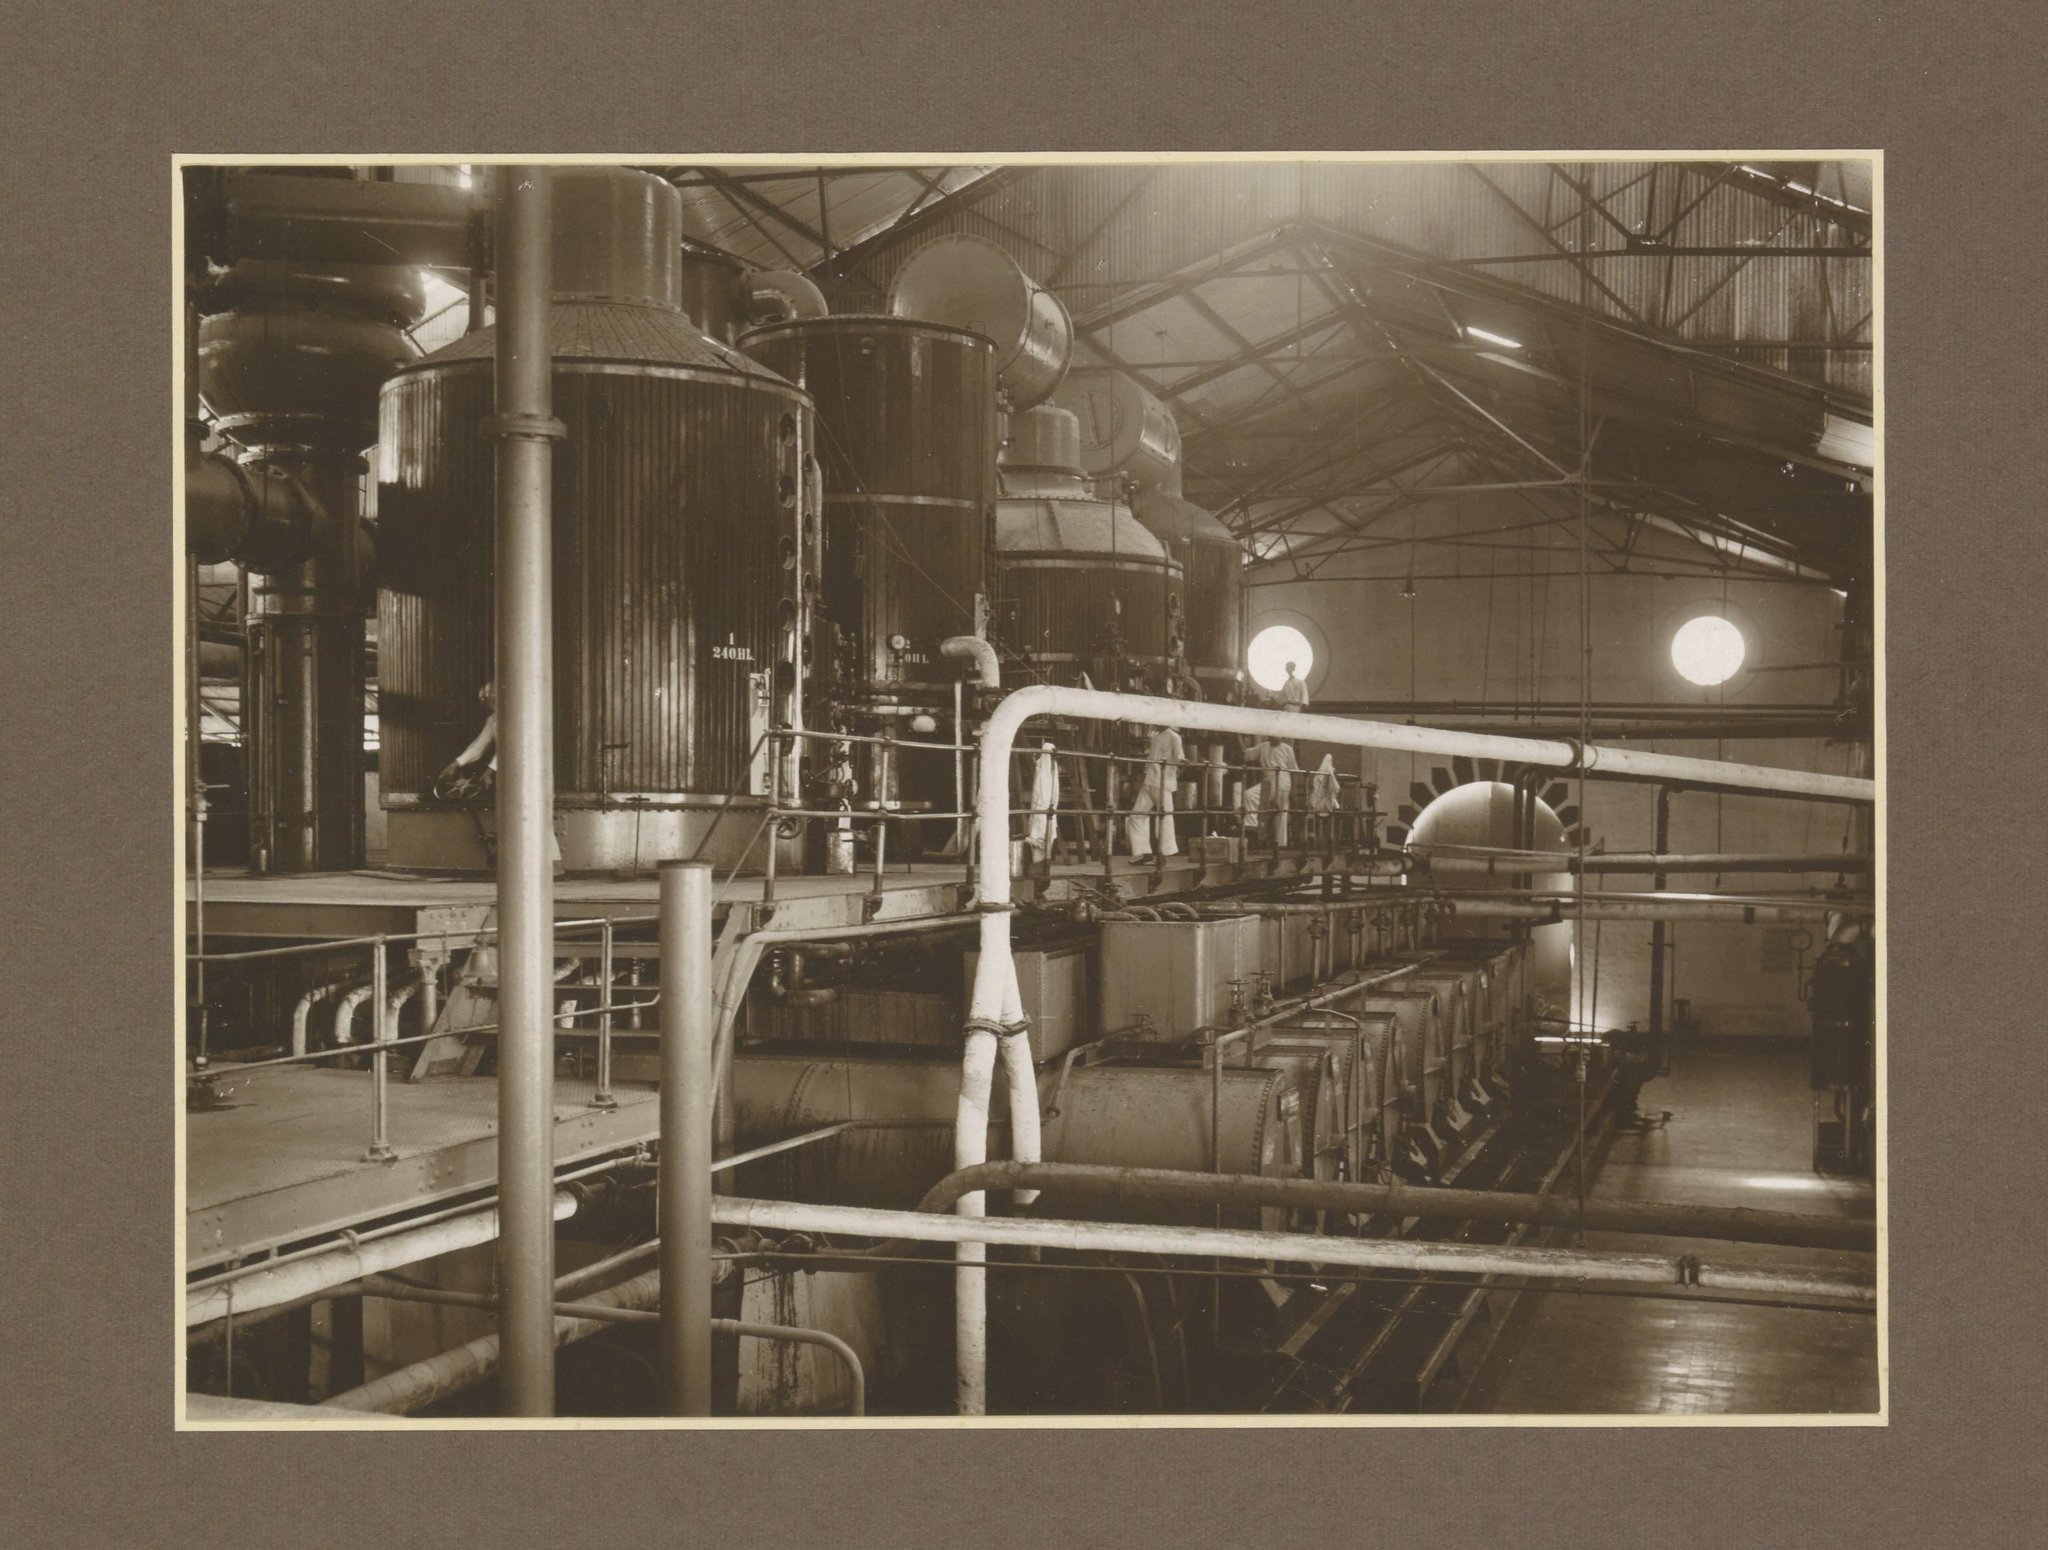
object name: photograph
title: Werknemers in het kookstation van suikerfabriek Boedoeran in Sidoarjo op Java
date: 1925-1930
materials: cardboard, paper, photographic support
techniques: gelatin silver print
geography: sidoarjo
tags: plantation, factory-interior, machine shop, plants and herbs: sugarcane, sugar, dutch east indies, the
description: Onderdeel van Fotoalbum met opnames van vier suikerfabrieken op Java.